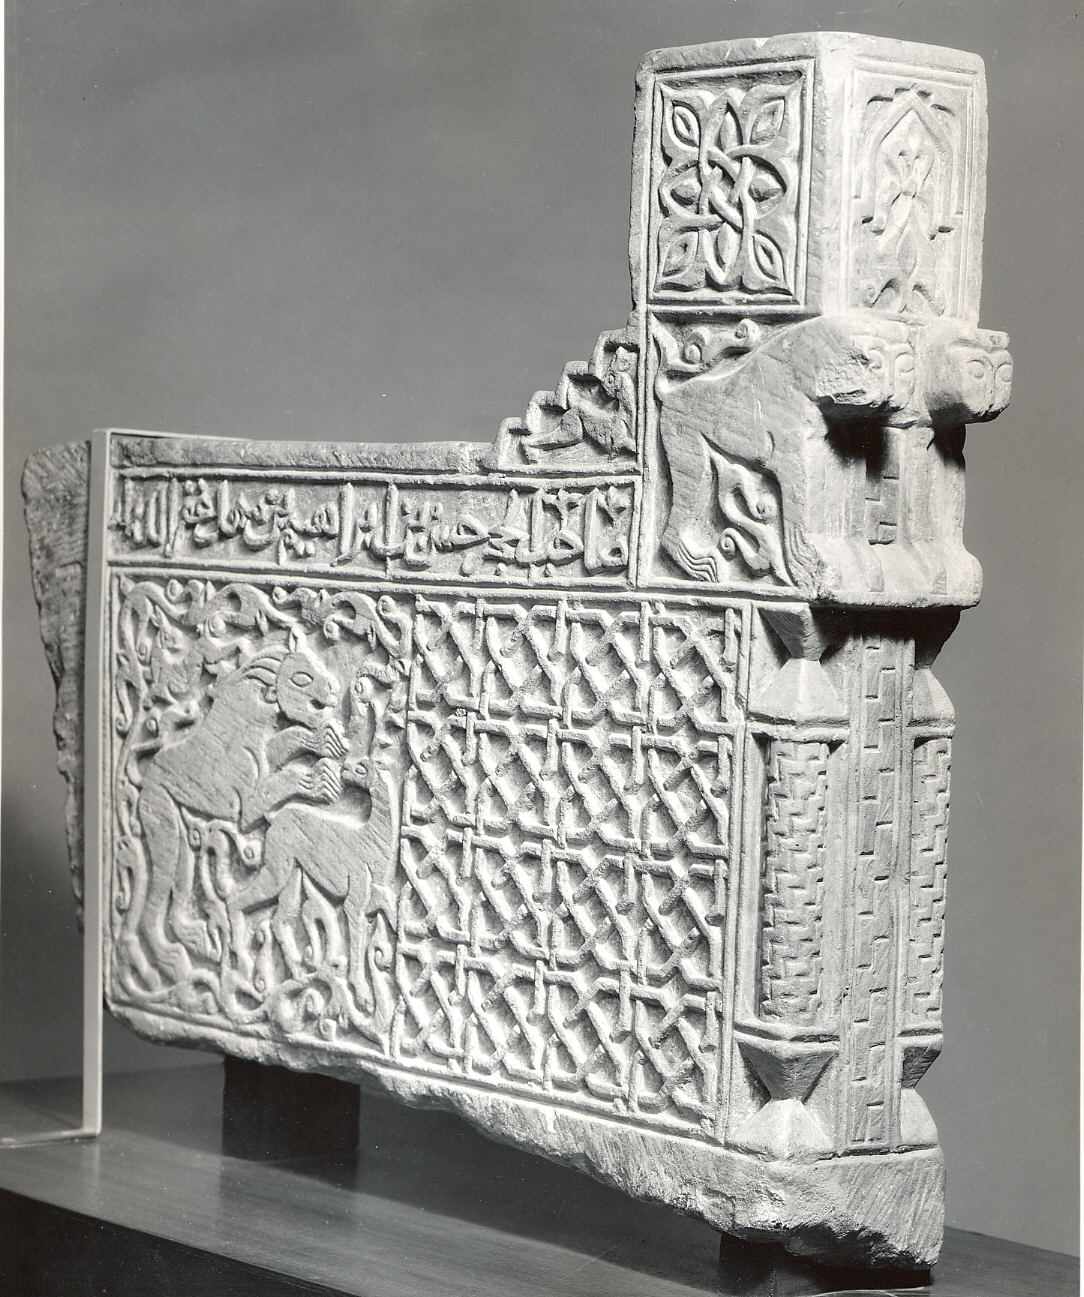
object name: balustrade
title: End of Balustrade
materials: limestone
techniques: carving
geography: iran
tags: animals